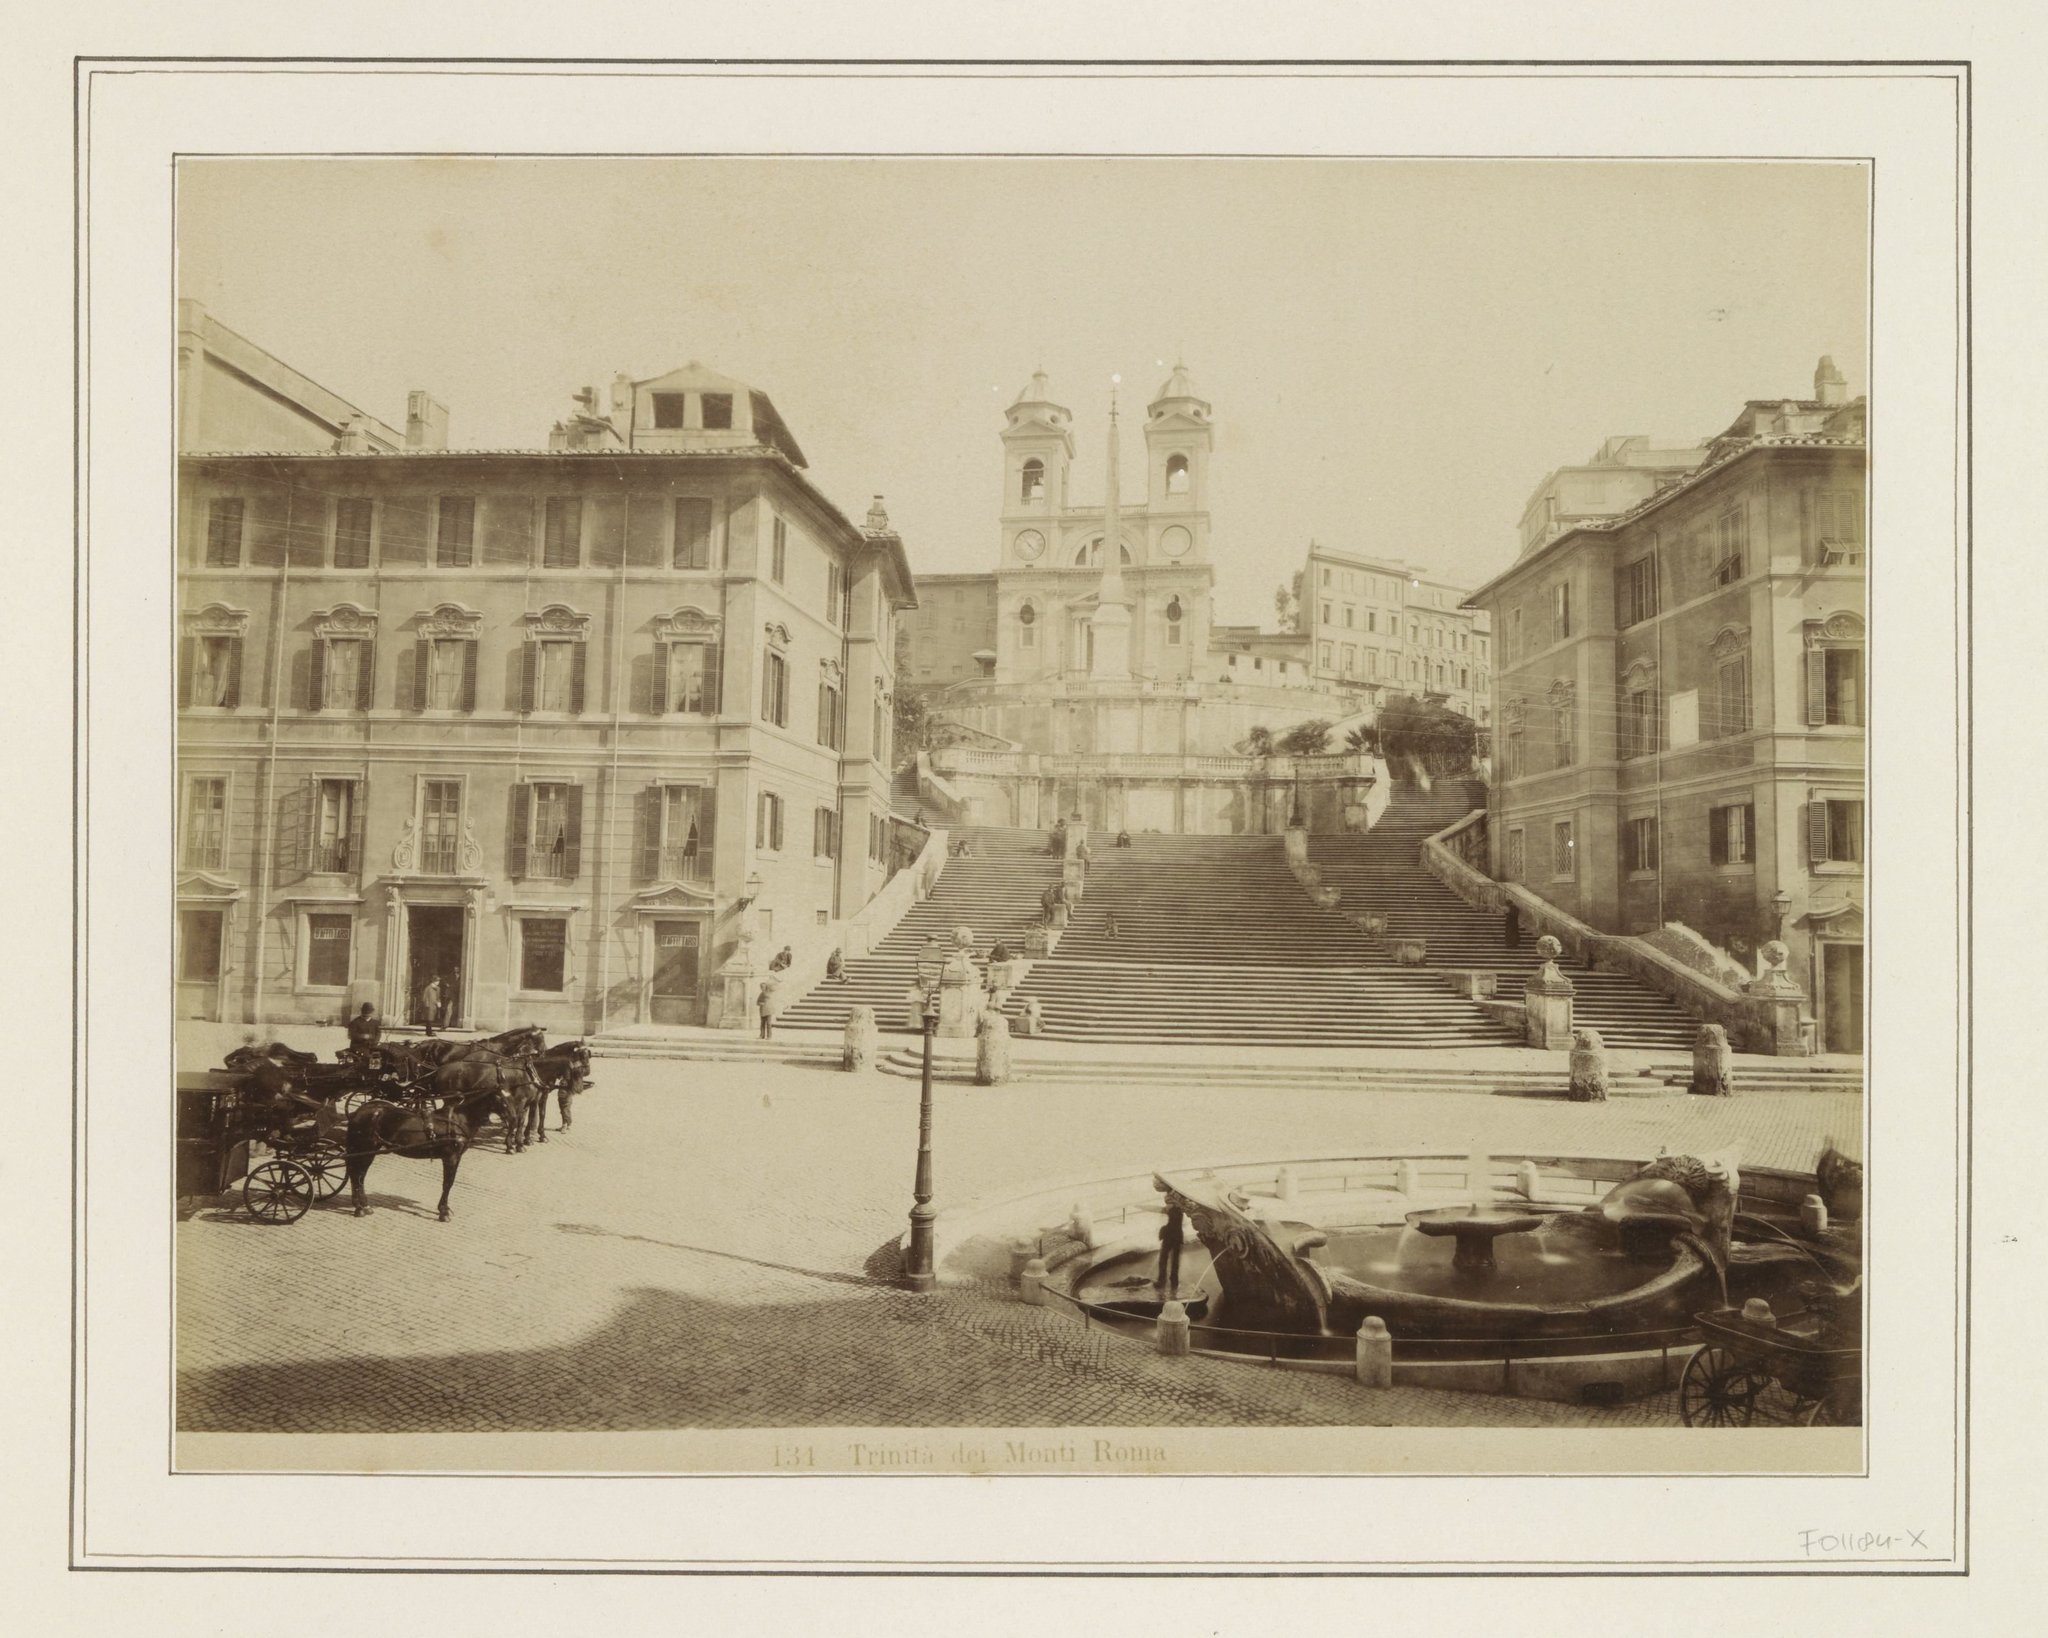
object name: photograph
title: Trinita dei Monti Roma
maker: Anonymous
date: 1865-1890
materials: paper, photographic support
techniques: albumen print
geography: rome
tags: sloping street; street with steps or stairs, church (exterior), rome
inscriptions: negative number: ‘134’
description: Onderdeel van Reisalbum met foto's van bezienswaardigheden in Italië (deel I).